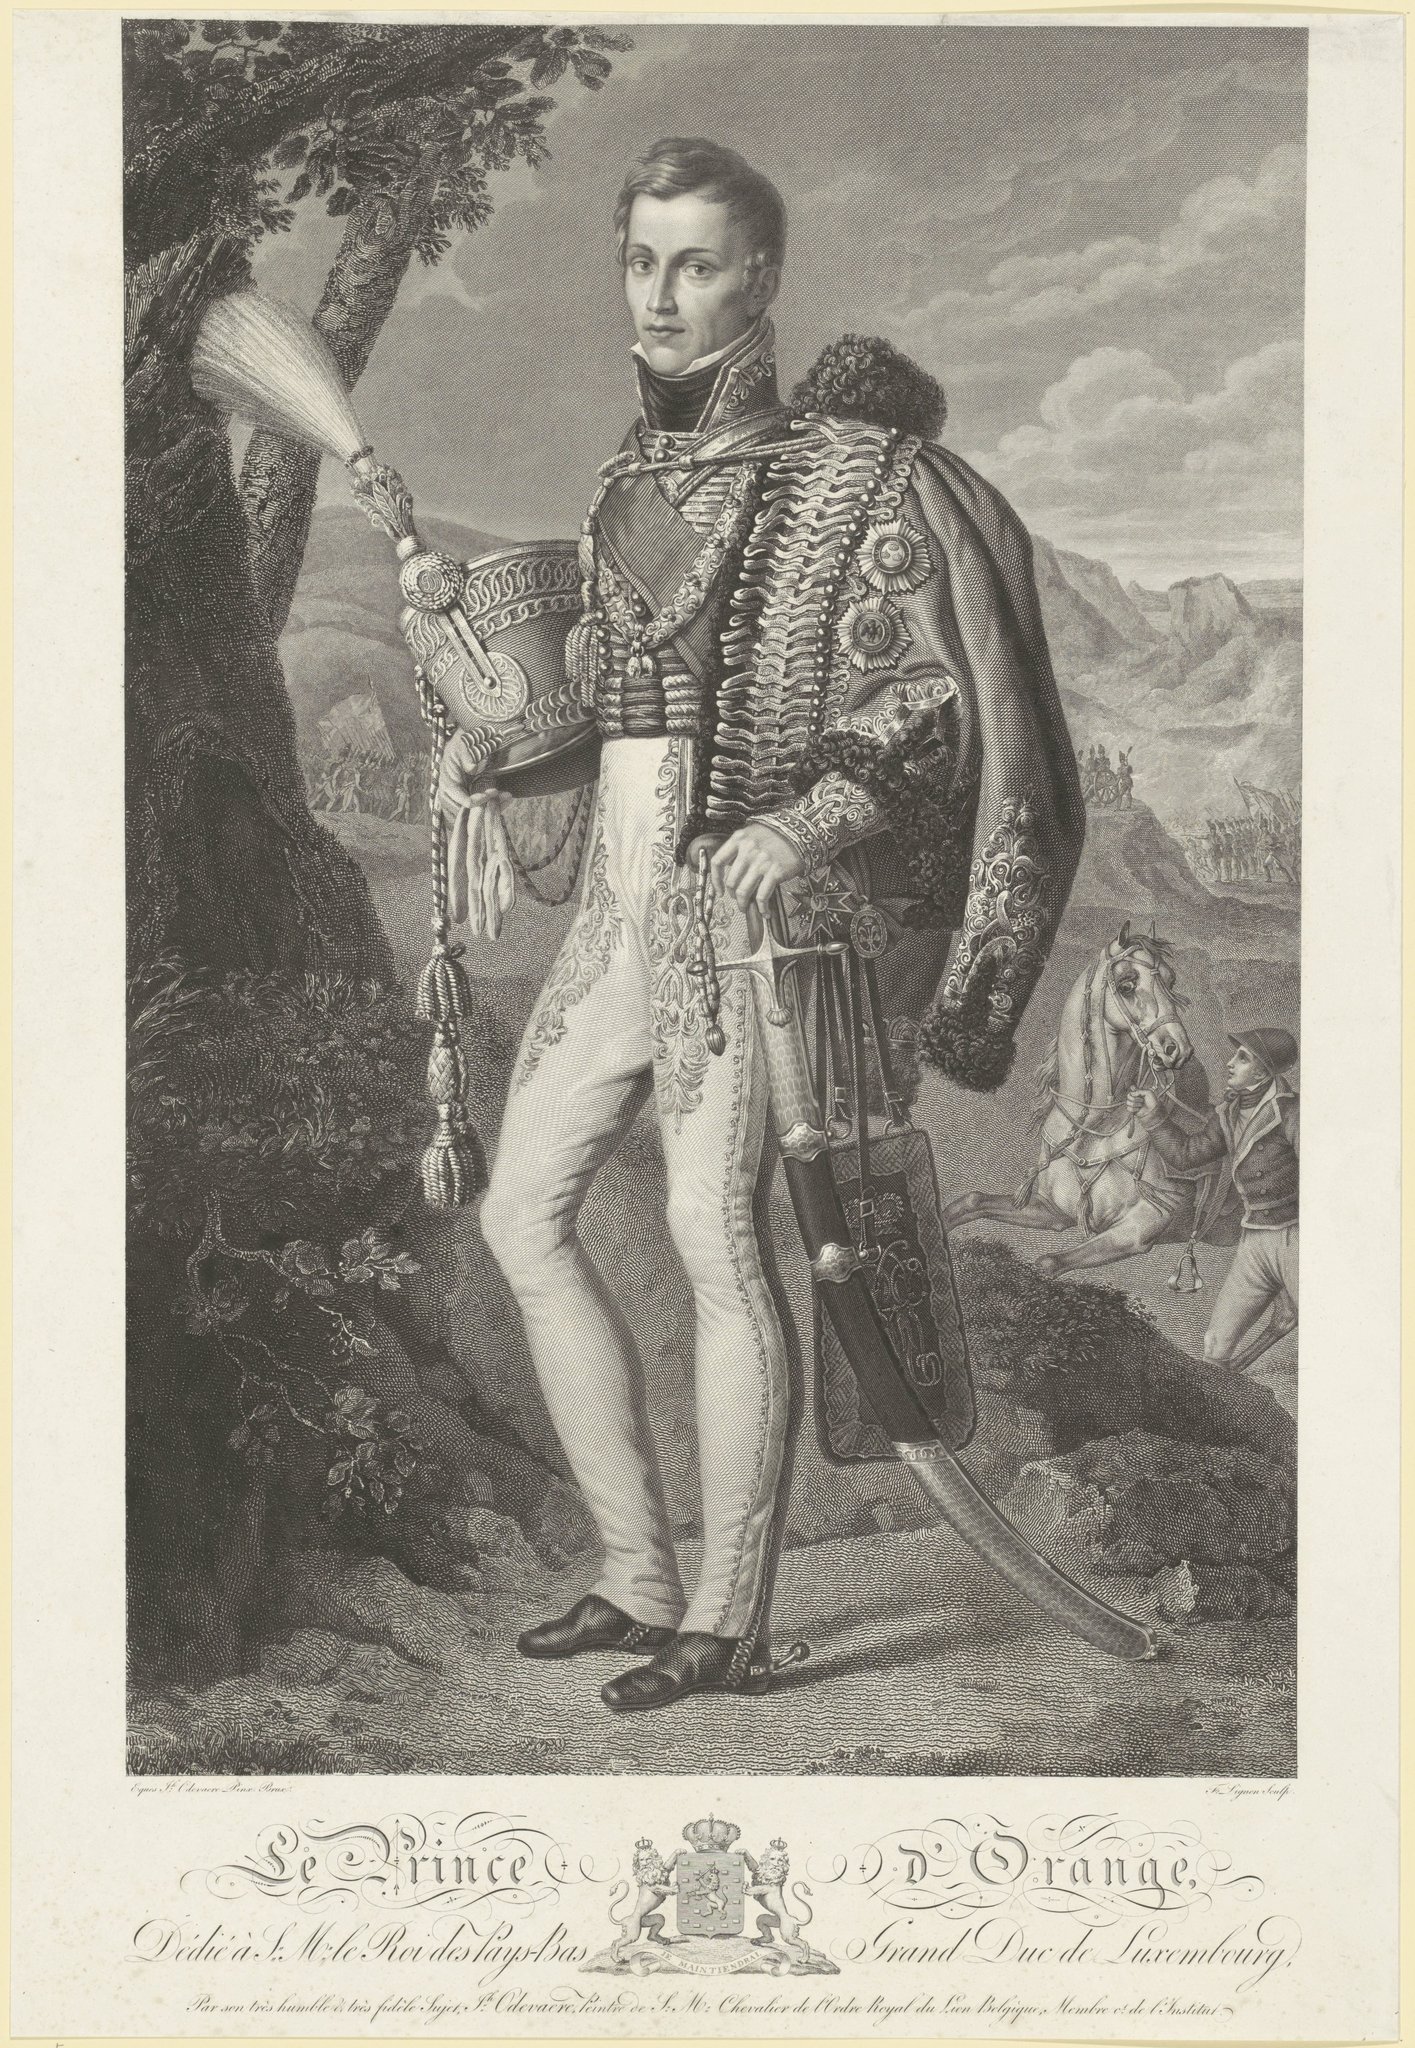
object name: print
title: Portret van Willem II, koning der Nederlanden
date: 1815-1833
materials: paper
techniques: engraving, etching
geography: netherlands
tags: william ii of the netherlands, knighthood order of the golden fleece - insignia of a knighthood order, e.g.: badge, chain (with name of order)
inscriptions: collector's mark: Lugt 963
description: Portret van Willem II in een huzarenuniform. Op de achtergrond een man met een paard. Midden onder zijn wapen met een kroon en twee leeuwen. Daaronder op een banderol zijn geslachtsspreuk. In de ondermarge zijn titel.